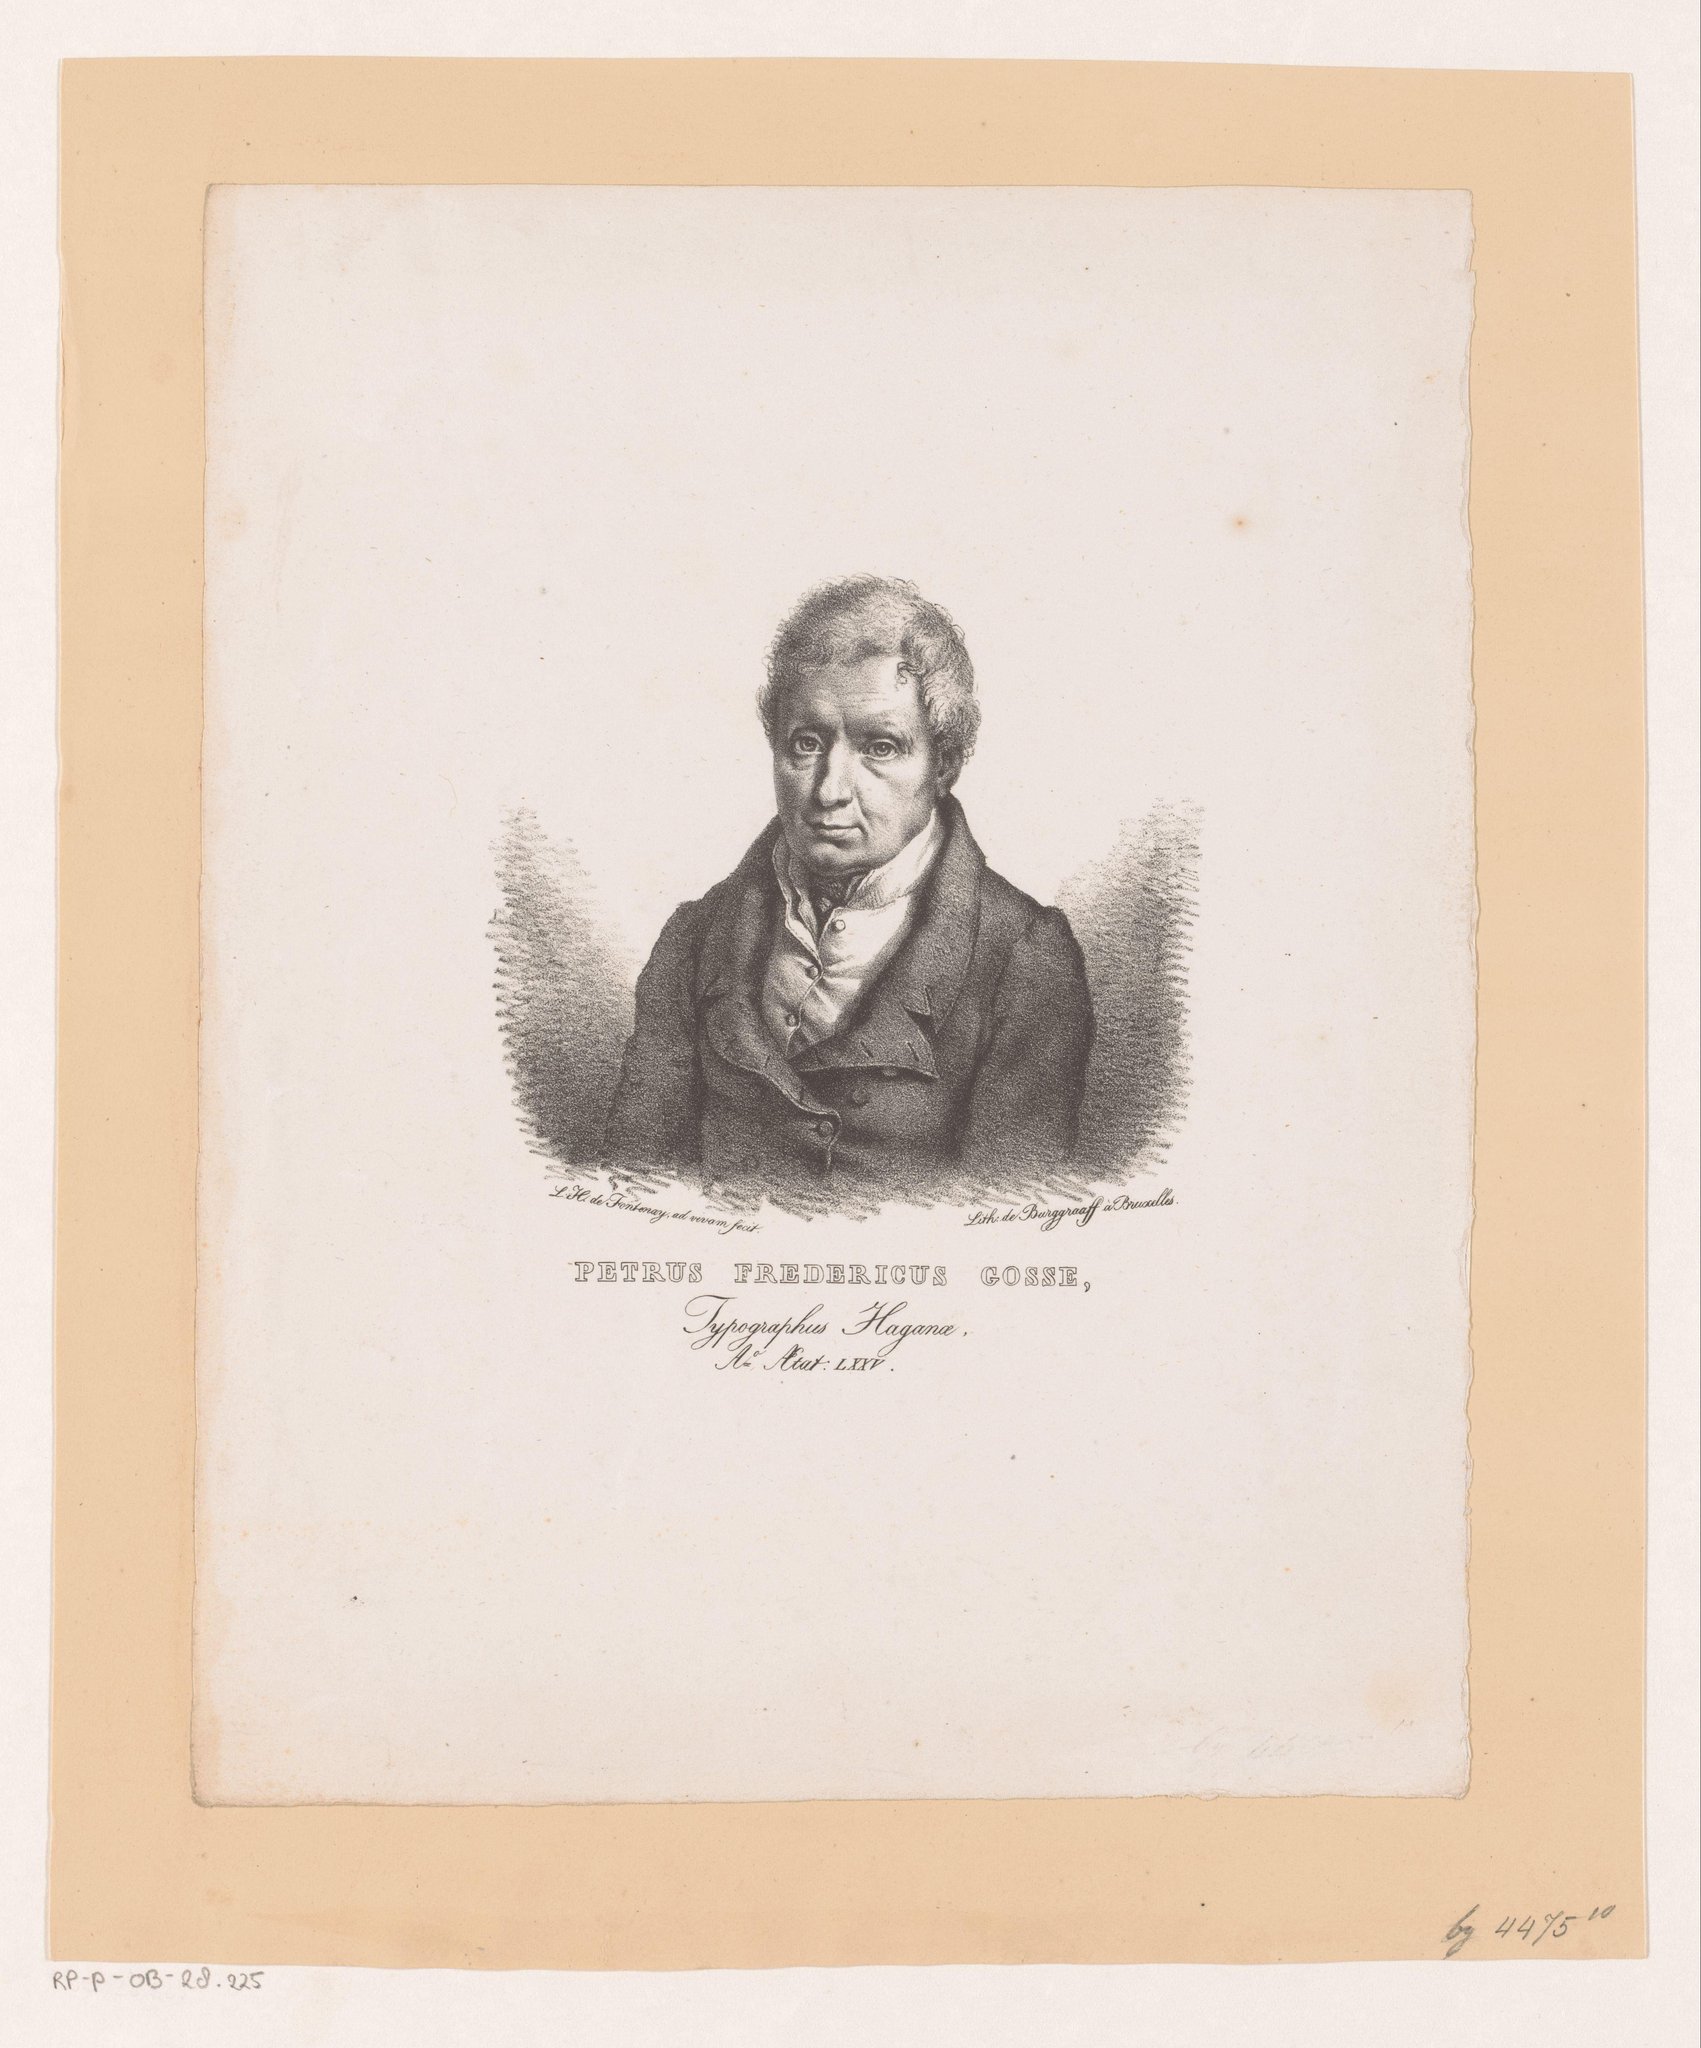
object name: print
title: Portret van Petrus Fredericus Gosse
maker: louis henri de fontenay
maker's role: draughtsman, print maker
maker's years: 1800-1872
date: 1810-1872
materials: paper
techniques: lithograph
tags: historical persons (+ (full) bust portrait)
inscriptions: collector's mark: Lugt 2228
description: Onder het portret de naam en het beroep van de geportretteerde: typograaf in Den Haag.